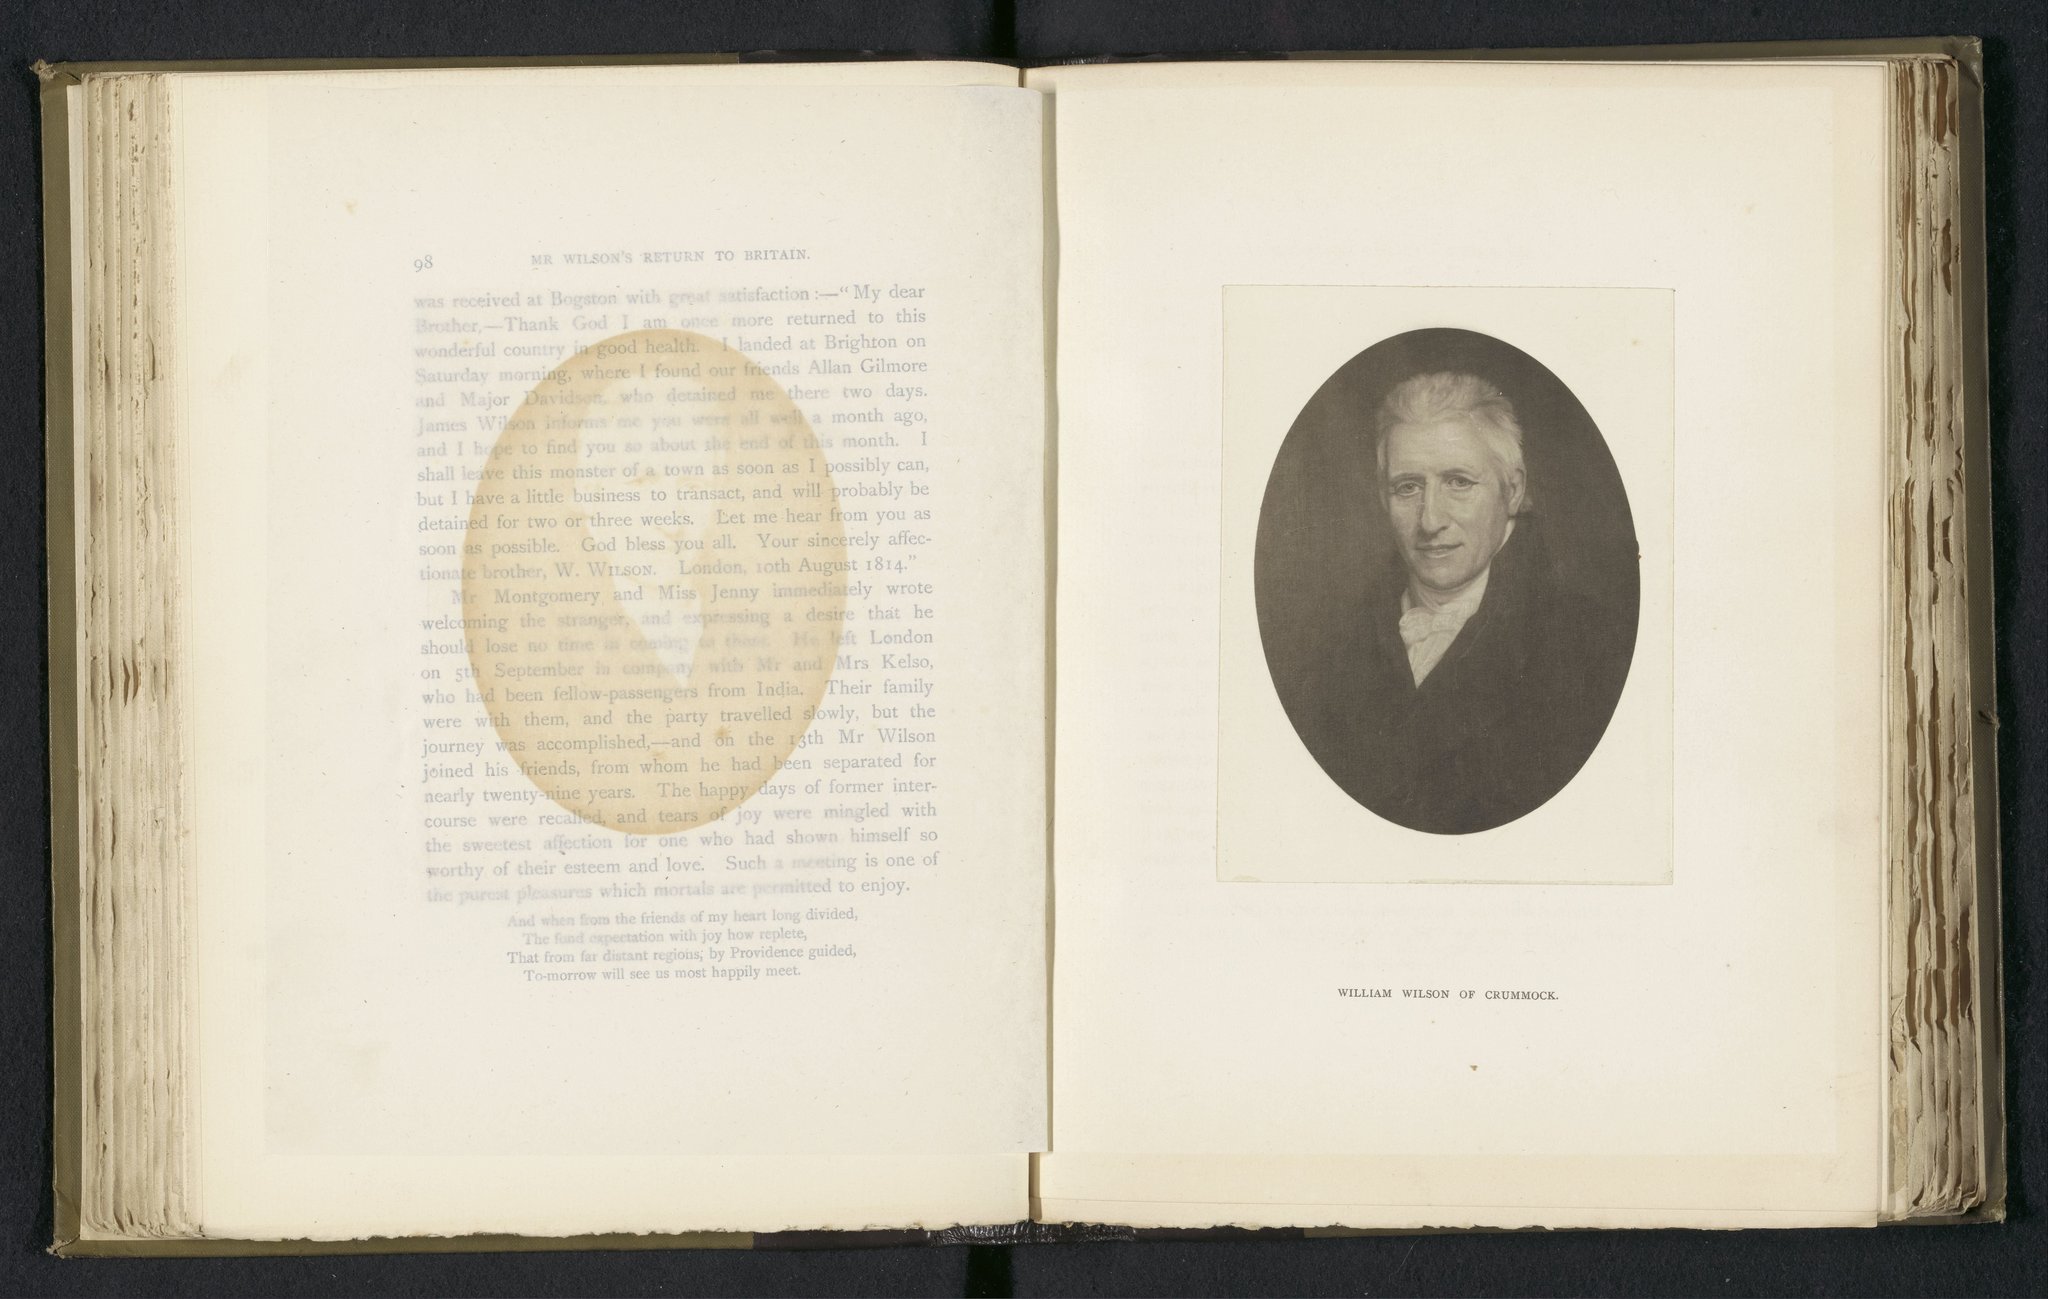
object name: page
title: William Wilson of Crummock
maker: Anonymous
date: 1886-1896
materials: photographic support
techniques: platinum process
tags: historical persons